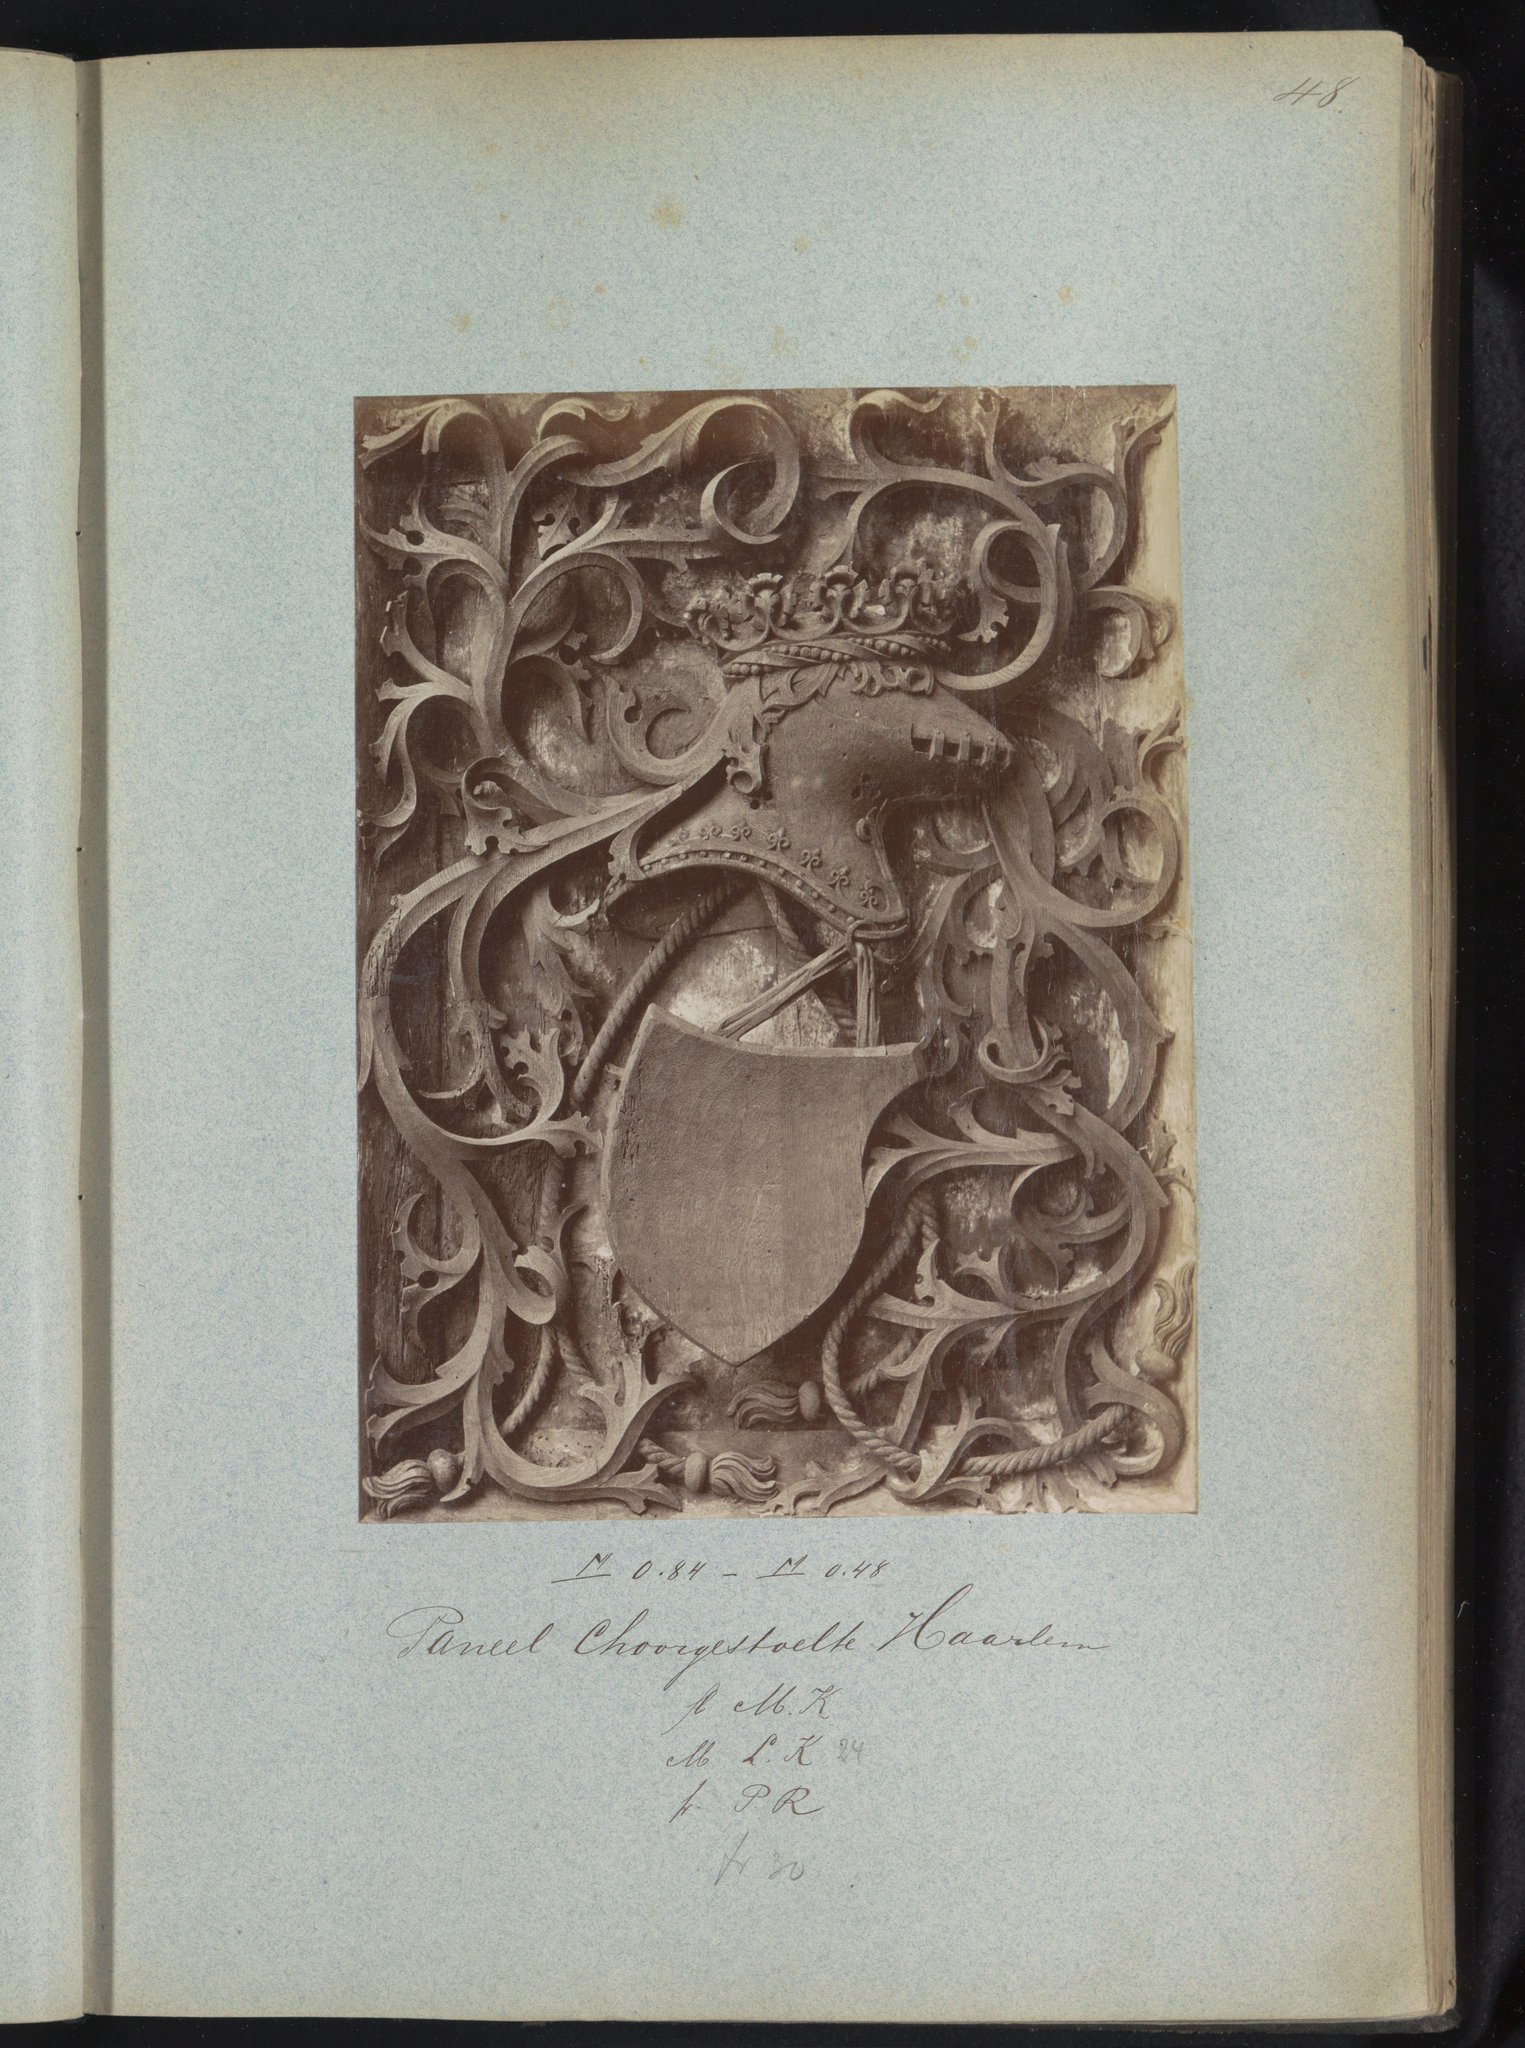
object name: album leaf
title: Gipsen afgietsel van een paneel van een koorgestoelte te Haarlem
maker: Anonymous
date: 1875-1900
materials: paper, photographic support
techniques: albumen print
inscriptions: annotation: ‘Paneel koorgestoelte Haarlem’, annotation, annotation: ‘M 0.84 - M 0.48’